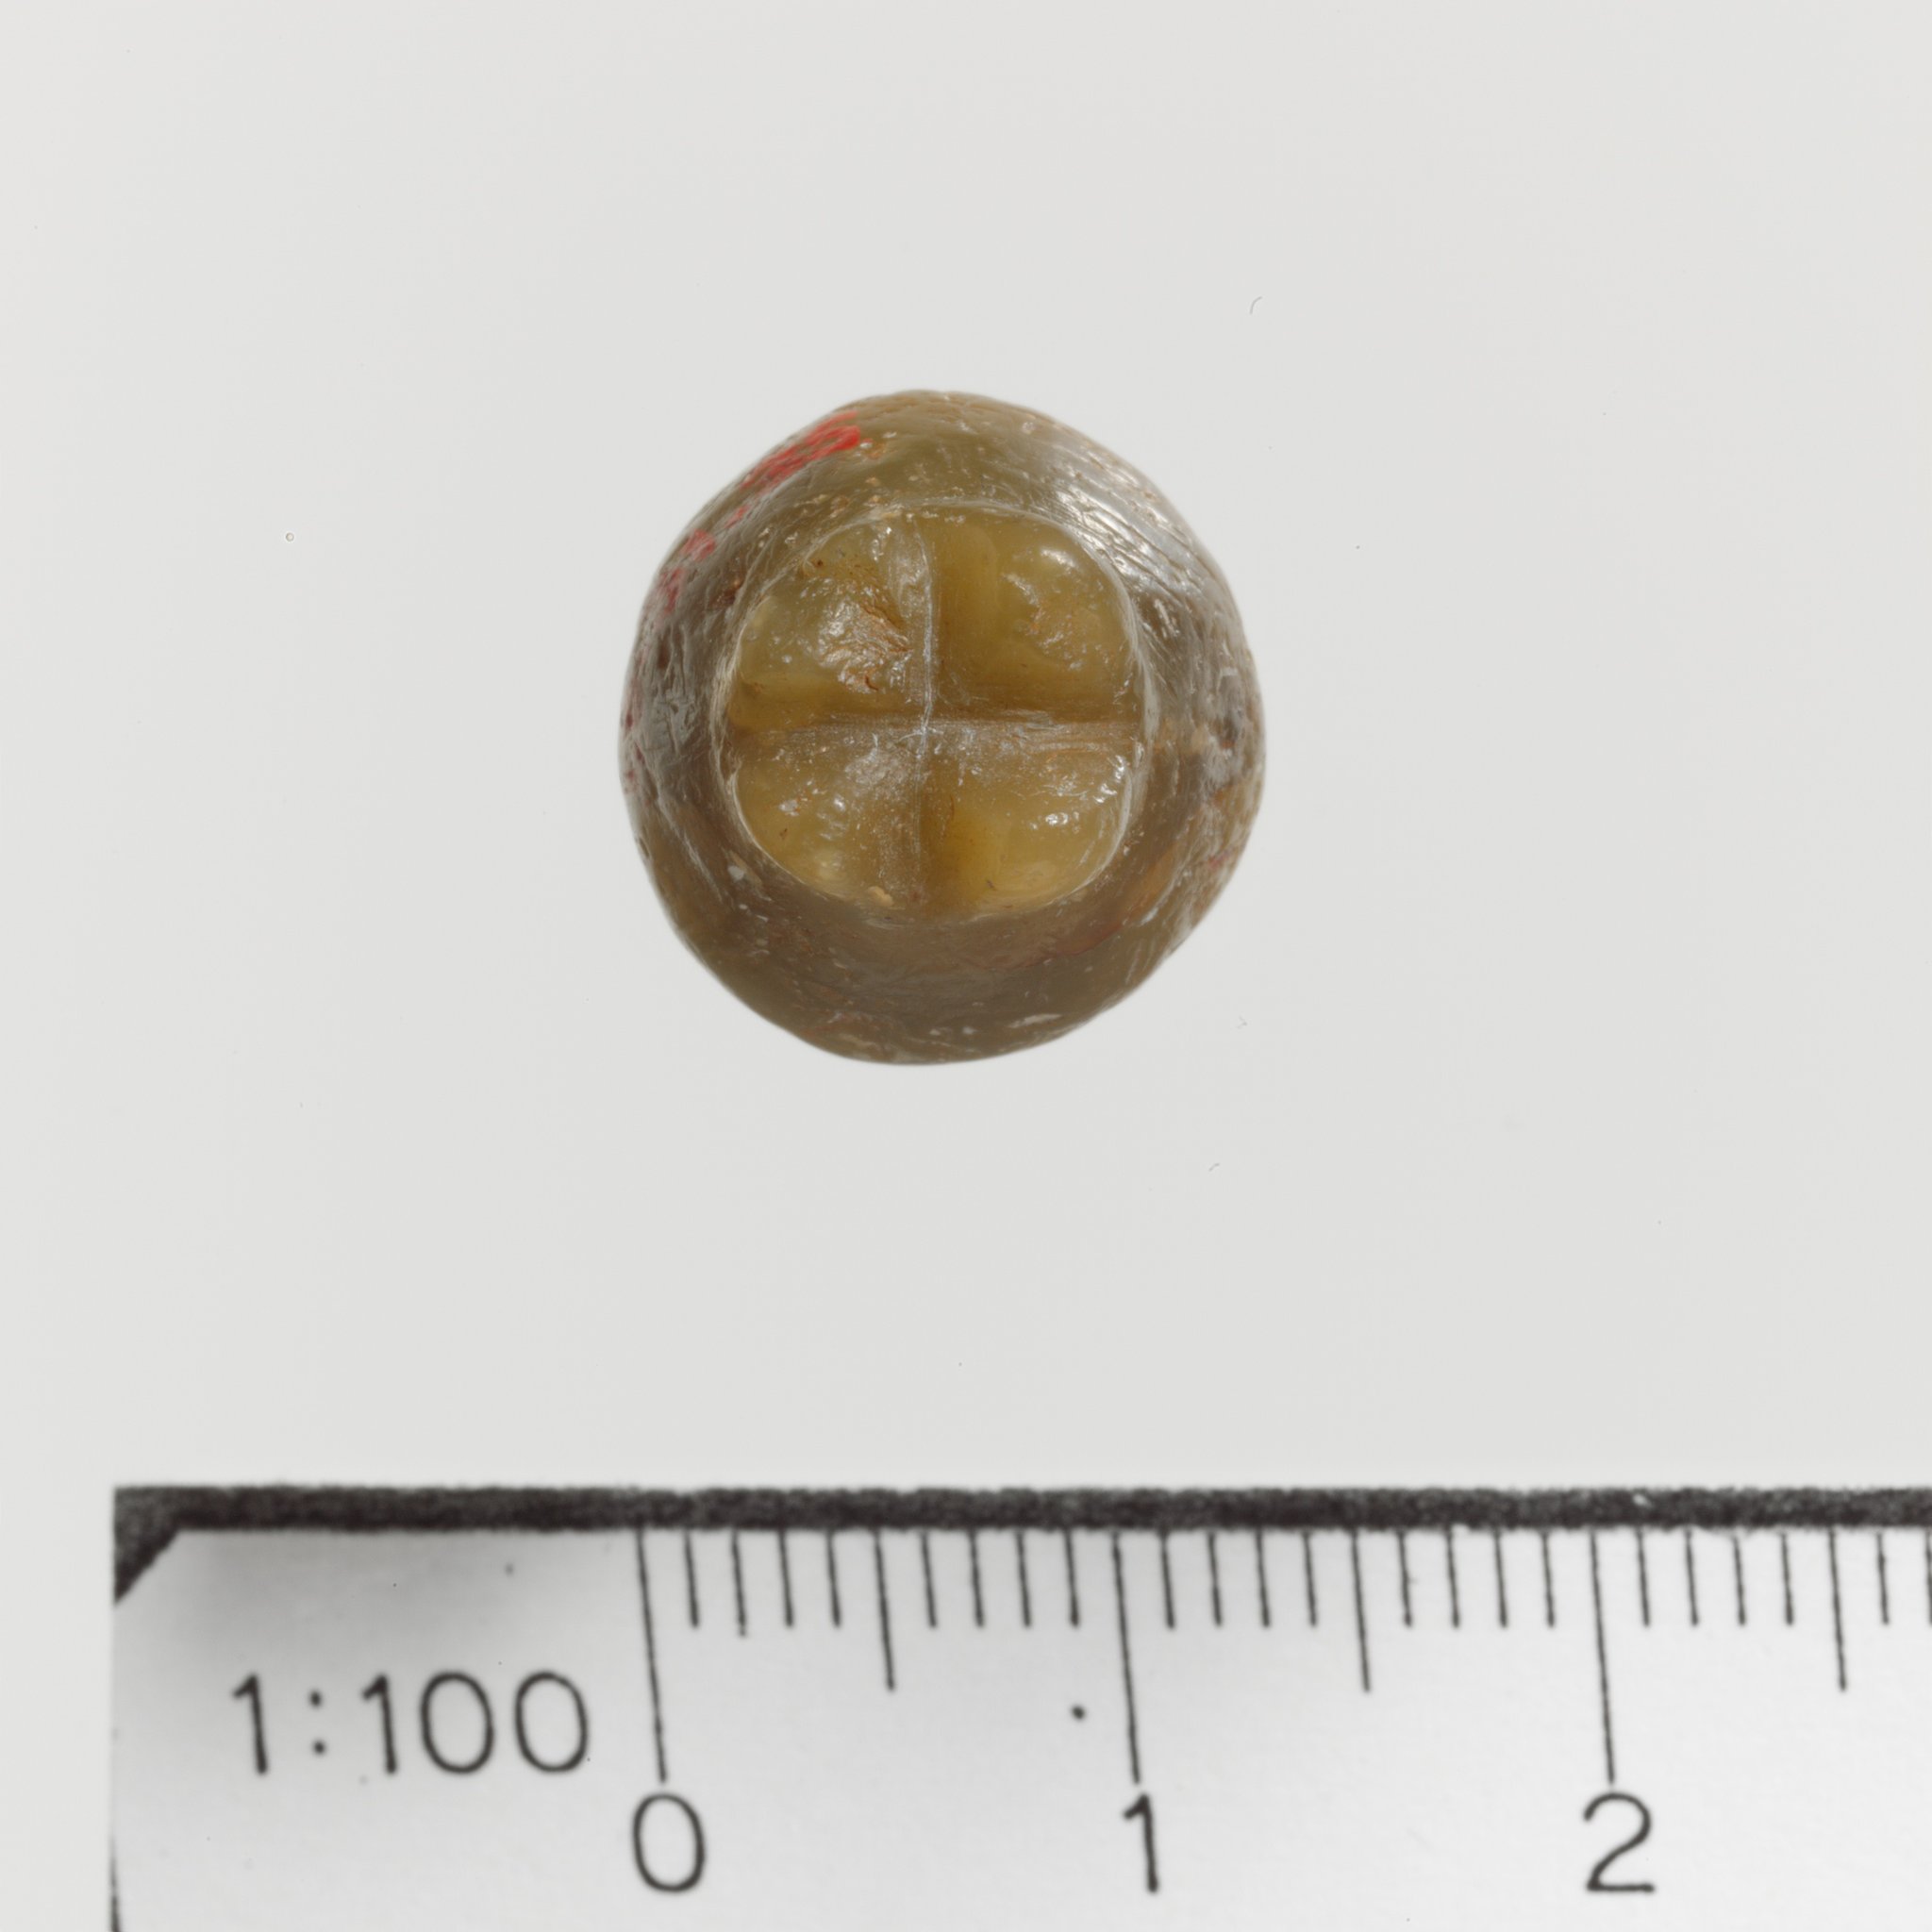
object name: stamp seal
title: Seal stamp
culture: minoan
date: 2200-1900 BCE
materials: stone